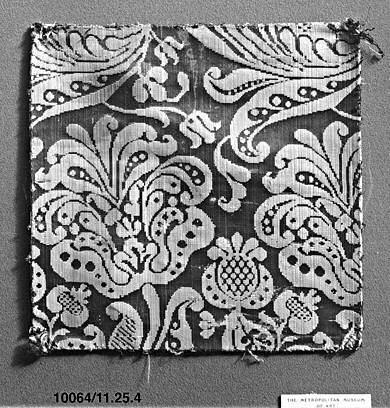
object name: piece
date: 1601-1700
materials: silk